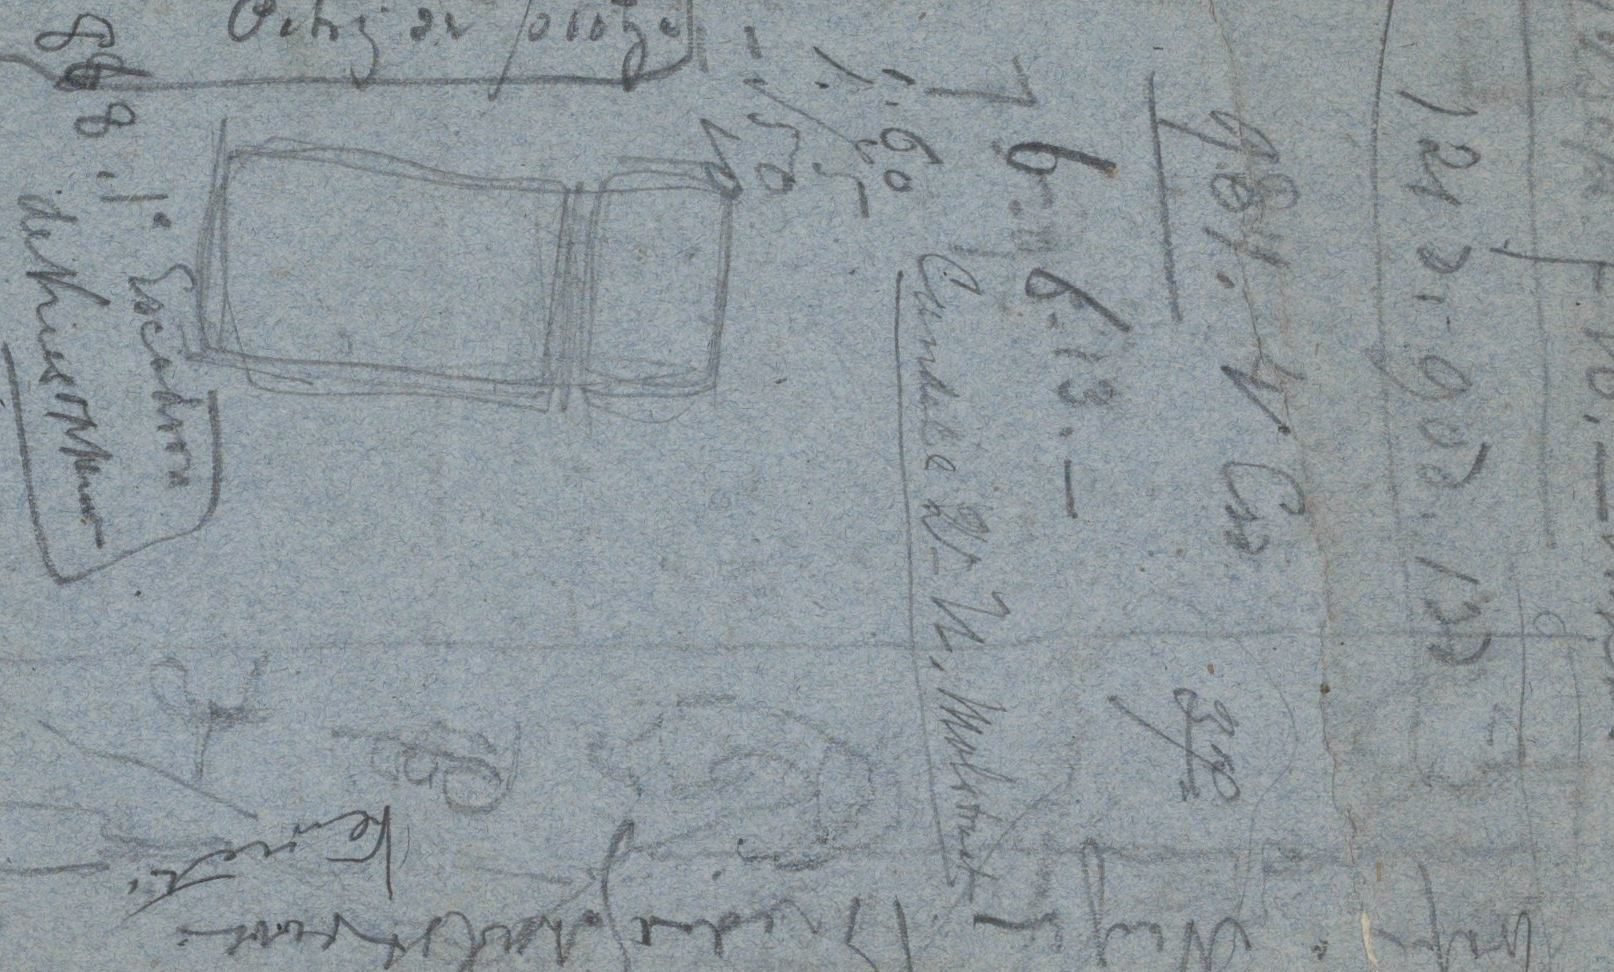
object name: sketchbook leaf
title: Studieblad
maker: george hendrik breitner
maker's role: draughtsman, painter, print maker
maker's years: 1857-1923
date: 1881-1883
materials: paper, pencil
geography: north brabant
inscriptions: annotation: ‘[...]’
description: Pagina 84, achterste schutblad, uit een schetsboek met 42 bladen.